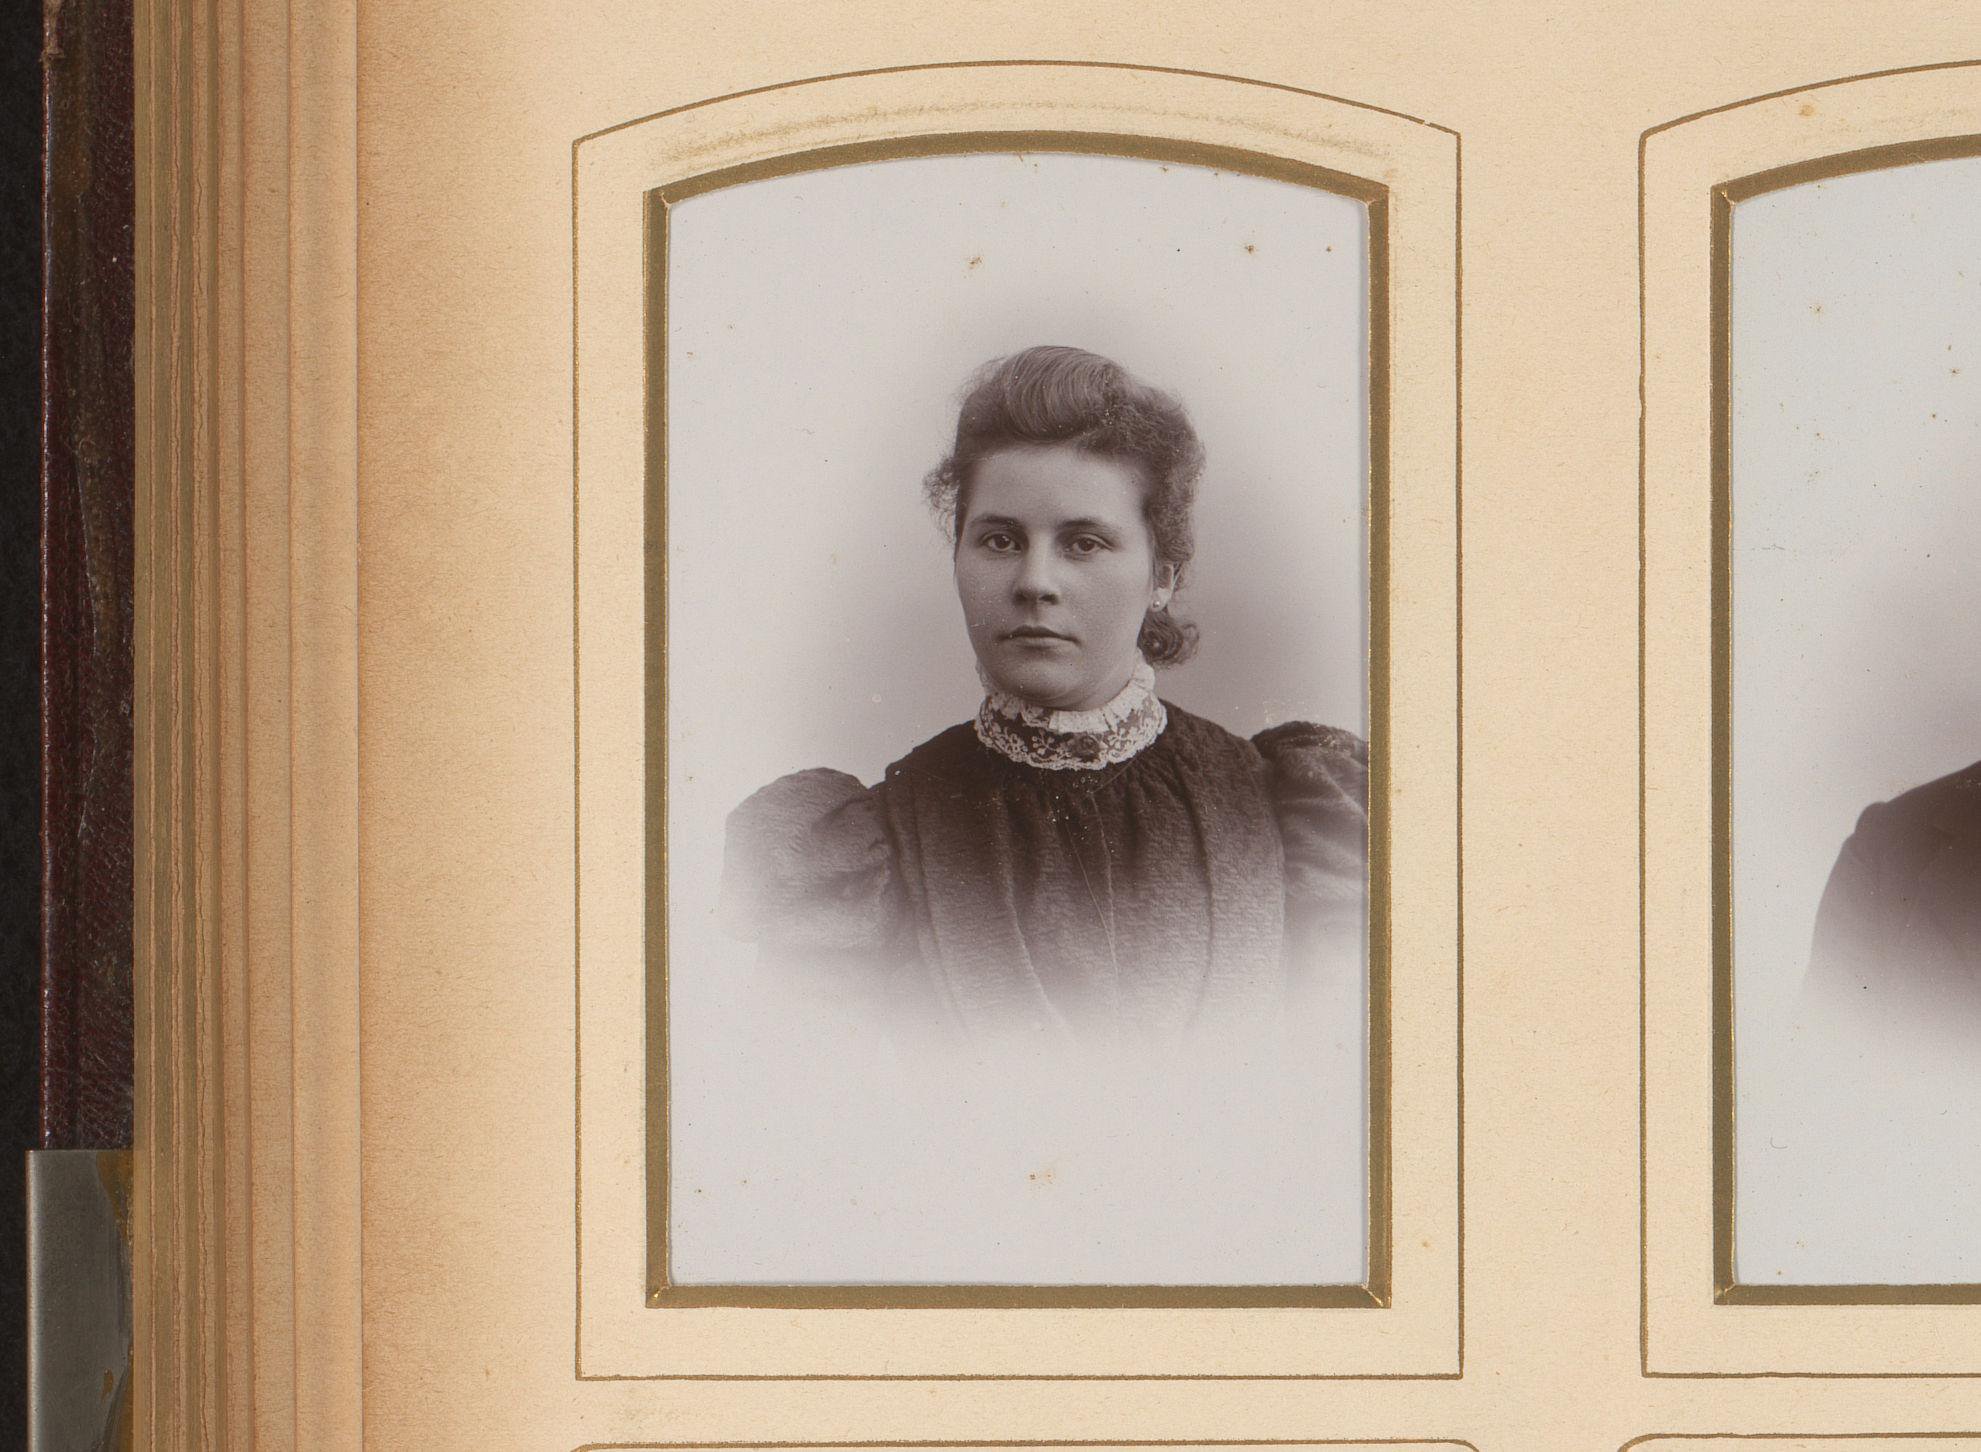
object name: photograph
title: Portret van een jonge vrouw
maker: machiel hendricus laddé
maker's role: fotograaf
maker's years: 1866-1932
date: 1892-1906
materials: cardboard, photographic support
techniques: collodion silver print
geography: amsterdam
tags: historical persons - bb - woman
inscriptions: inscription: ‘No. .../ Photographie/ Artistique/ M. H. Laddé/ boven de Firma/ MERKELBACH & Co./ Amsterdam/ Nieuwendijk 57-59./ Het Cliche wordt voor verdere bestellingen bewaard’